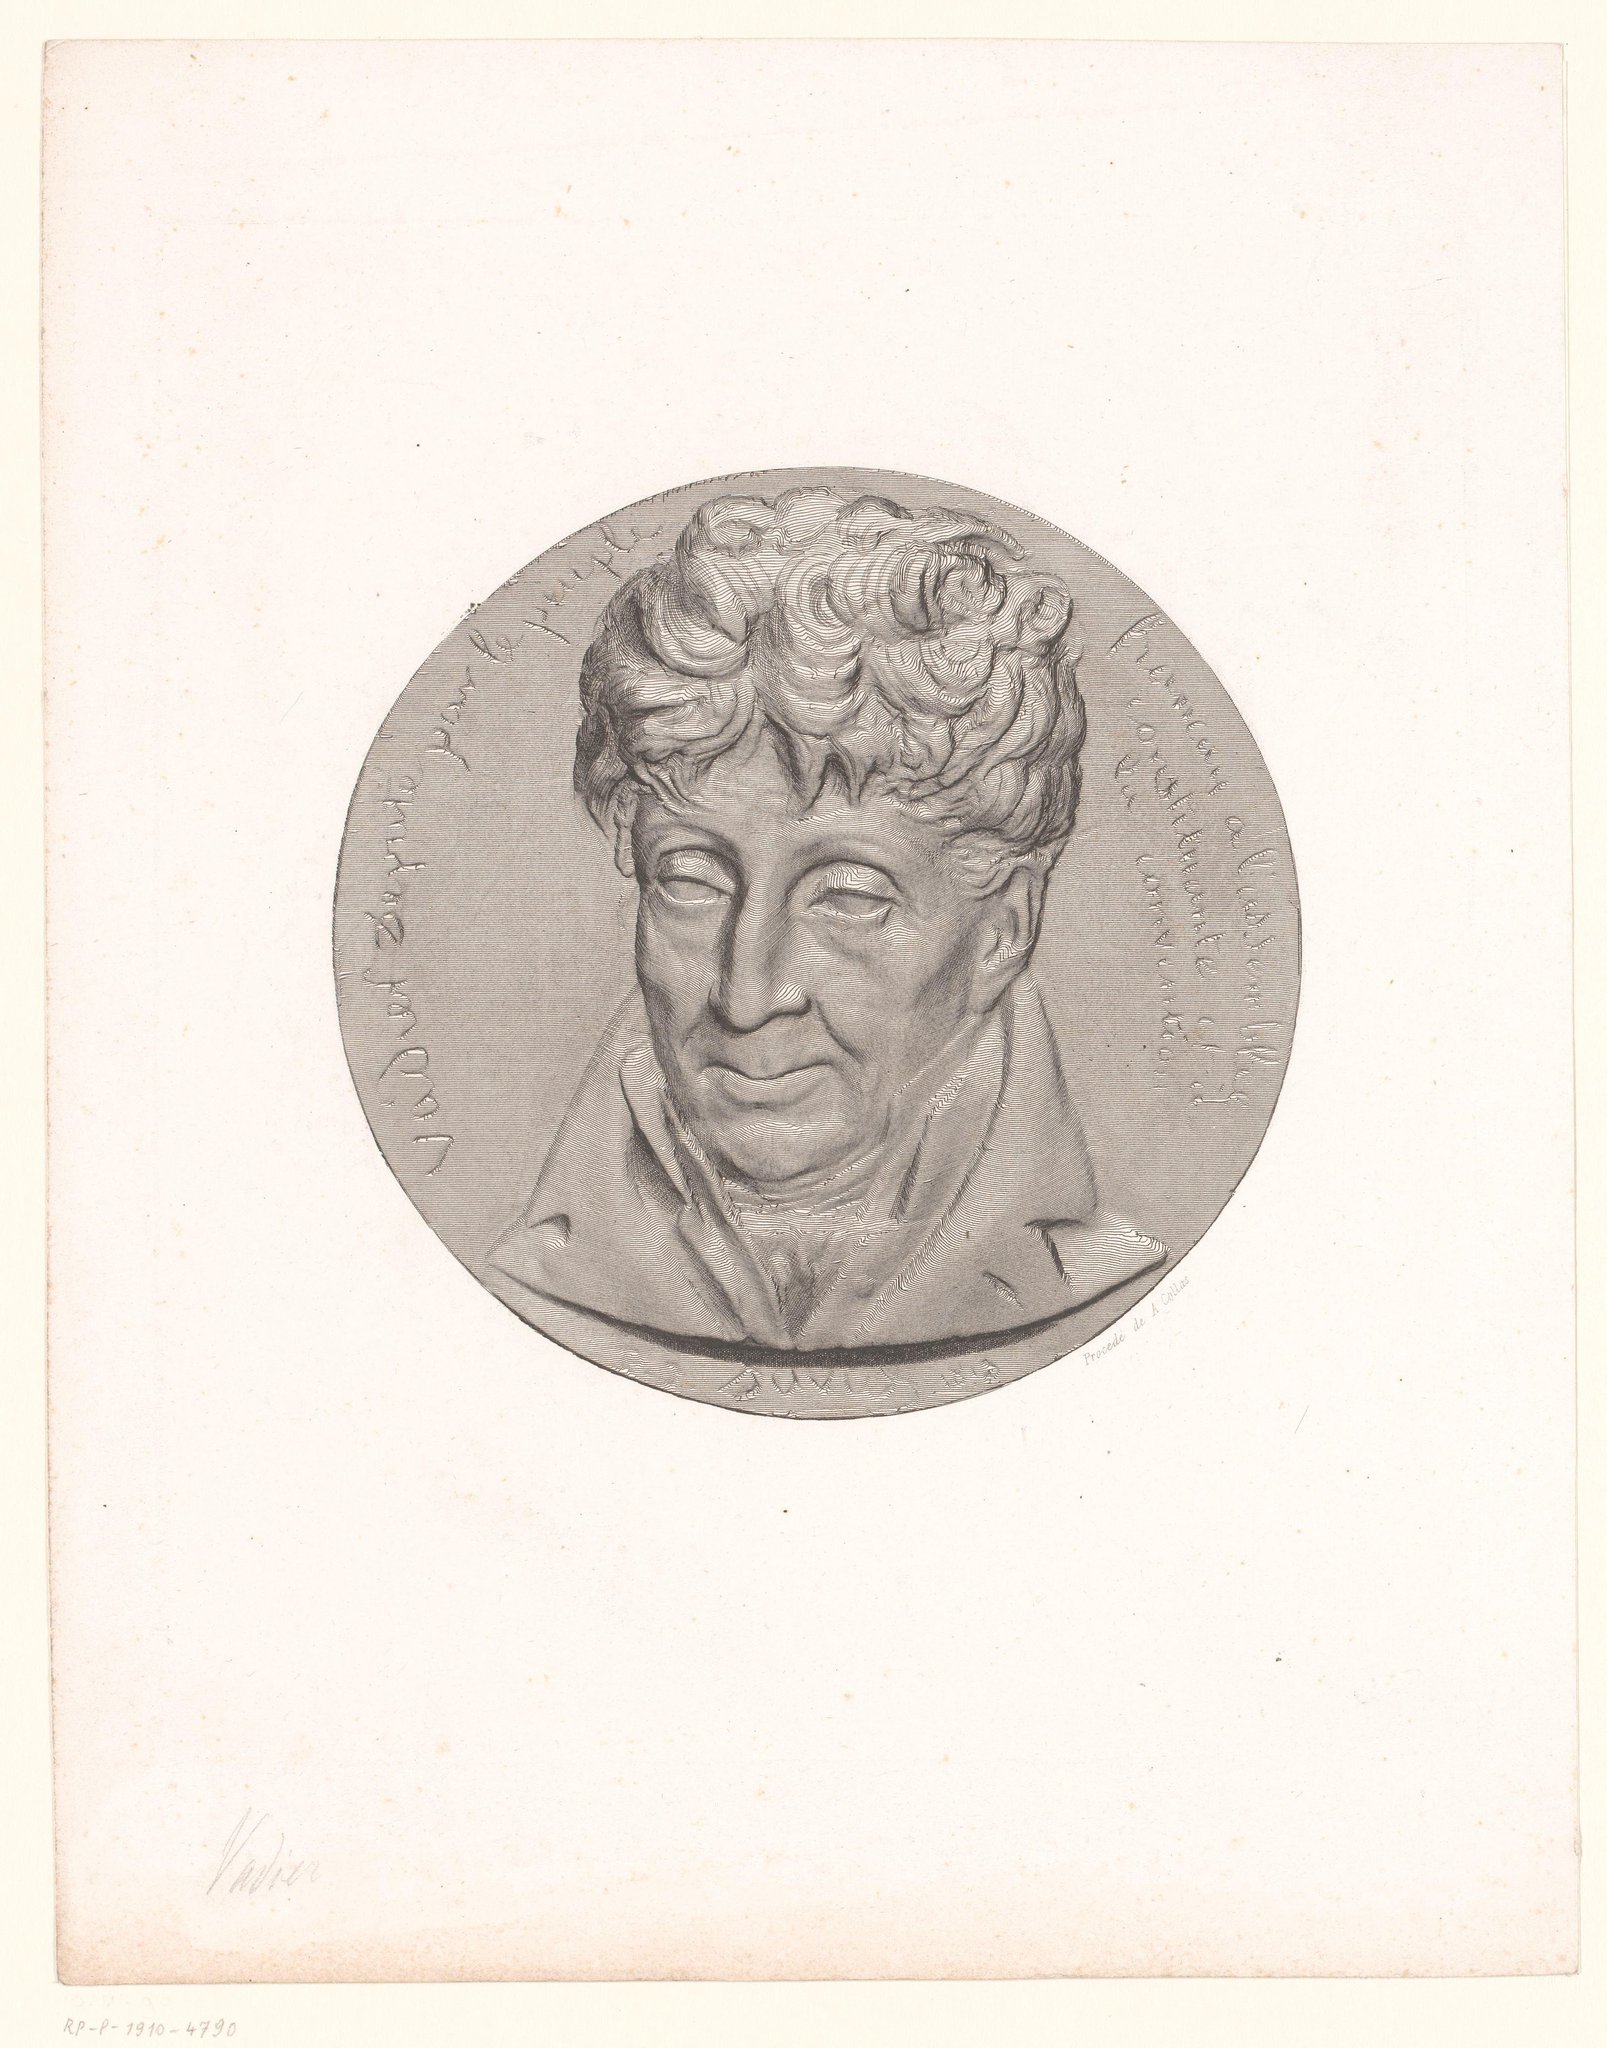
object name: print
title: Vadier deputé par le peuple francais (...)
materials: paper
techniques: relief engraving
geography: france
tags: brussels, politician, ornament ~ medallion, historical persons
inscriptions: collector's mark: Lugt 2228